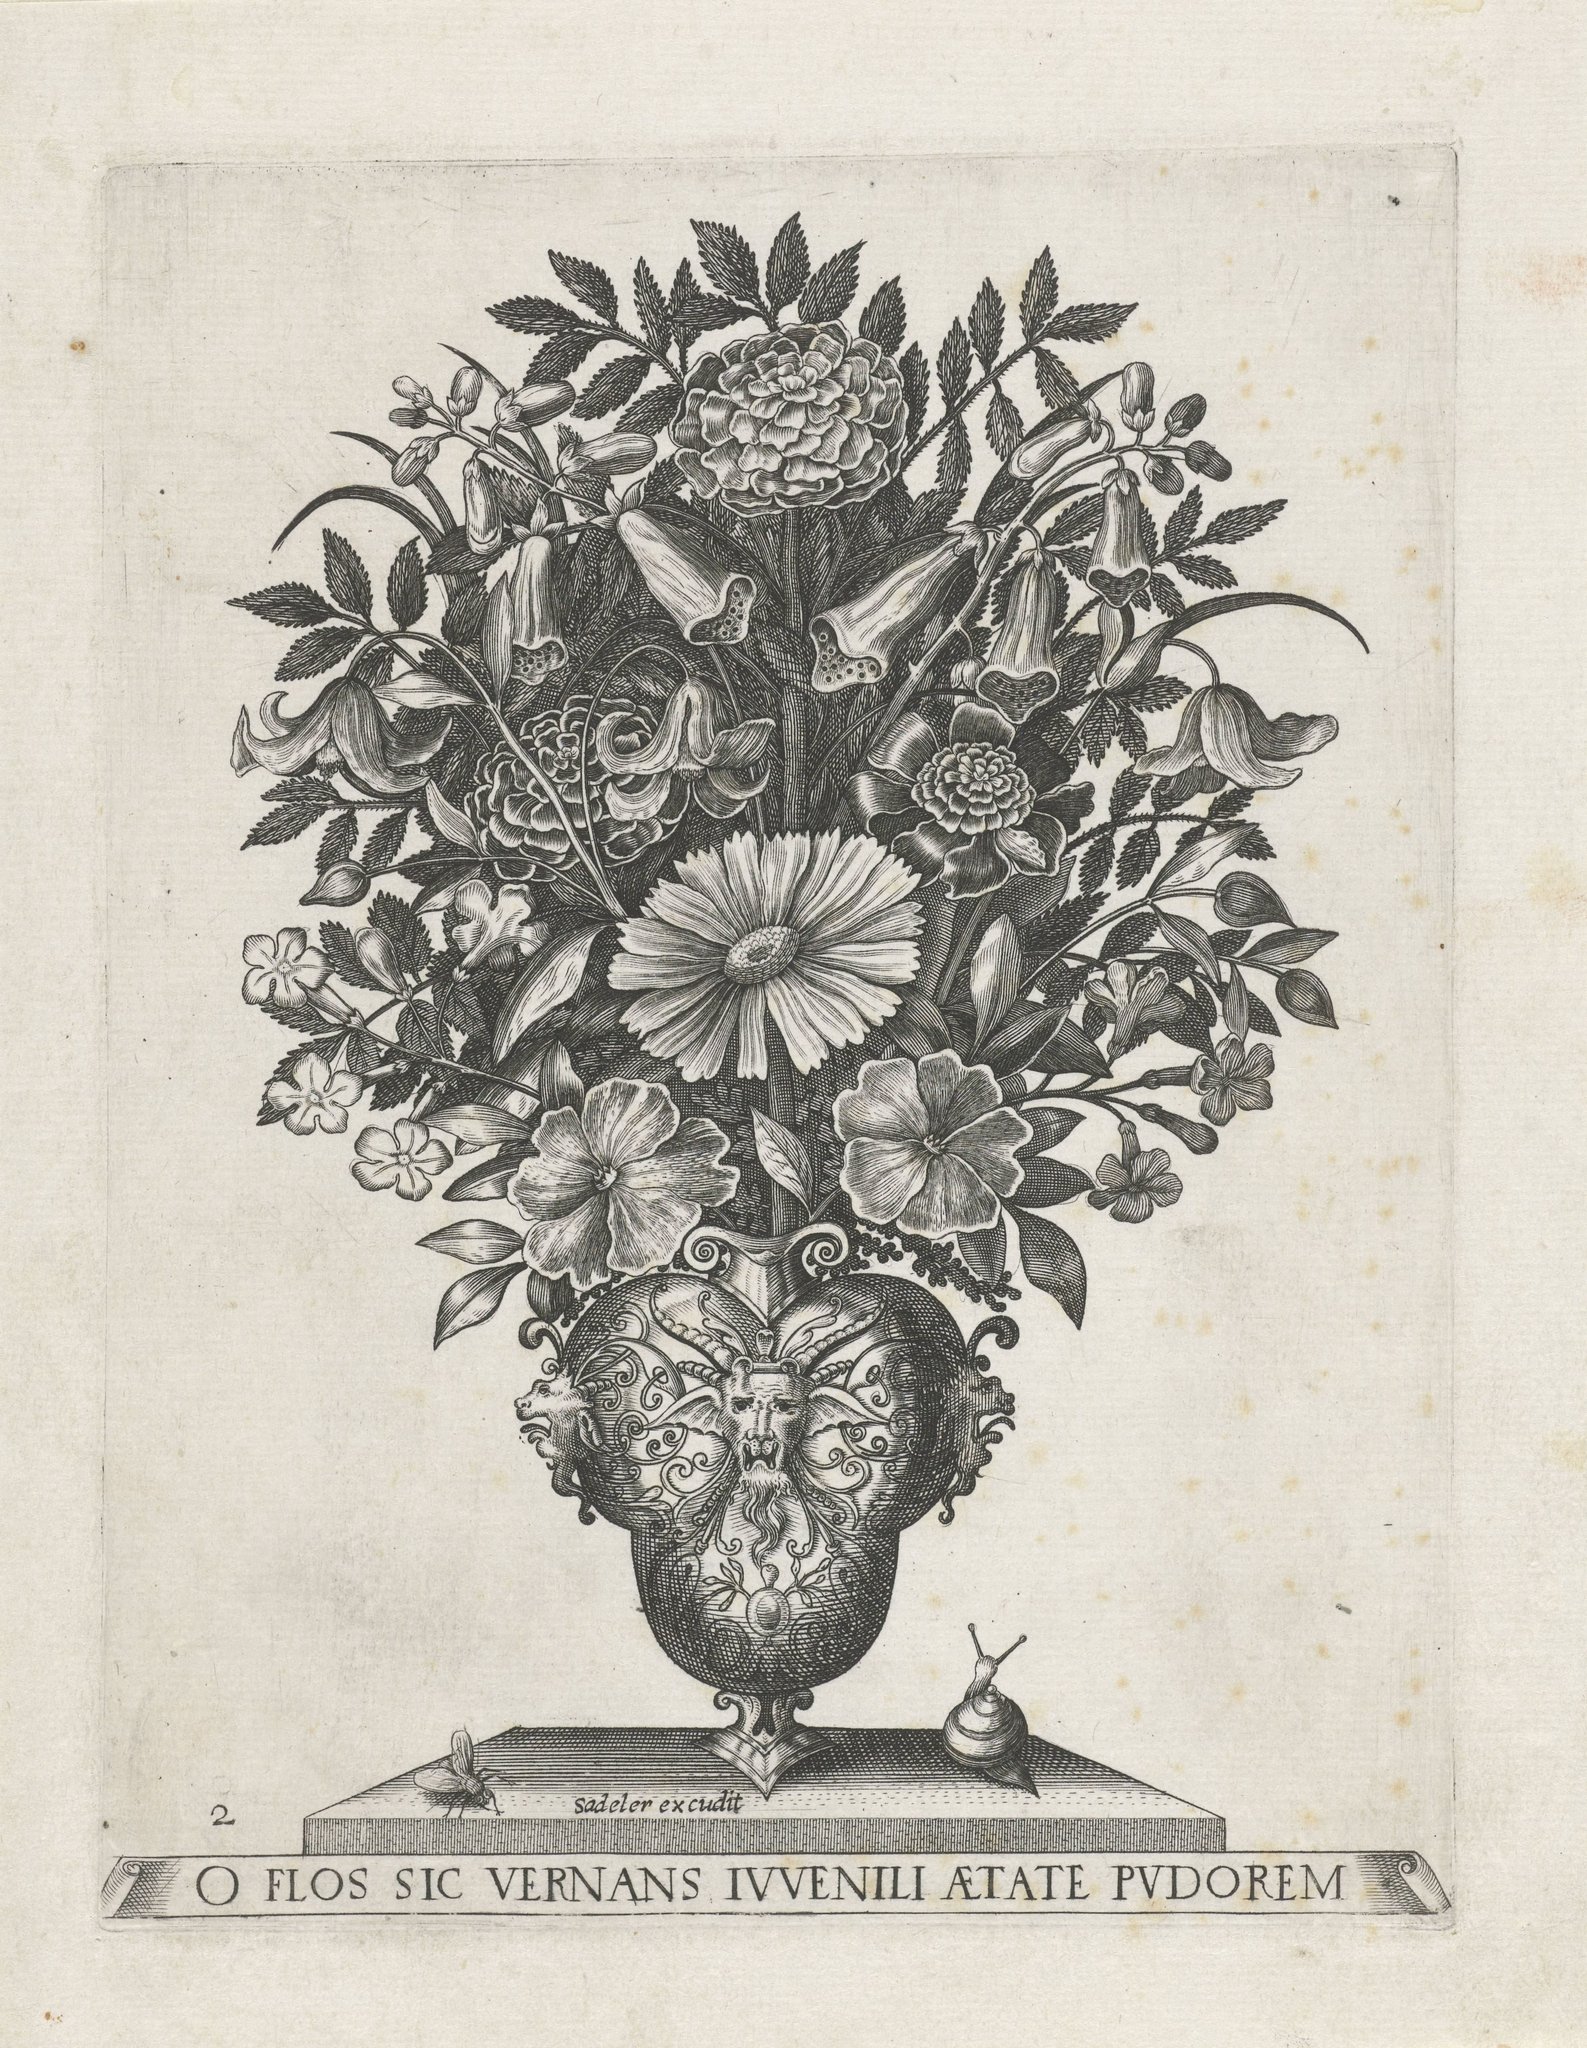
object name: ornament print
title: Vazen met bloemen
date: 1500-1600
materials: paper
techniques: engraving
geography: germany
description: In de vaas staan ondermeer rozen en een helianth. Rechts van de vaas kruipt een slak, links zit een insect.